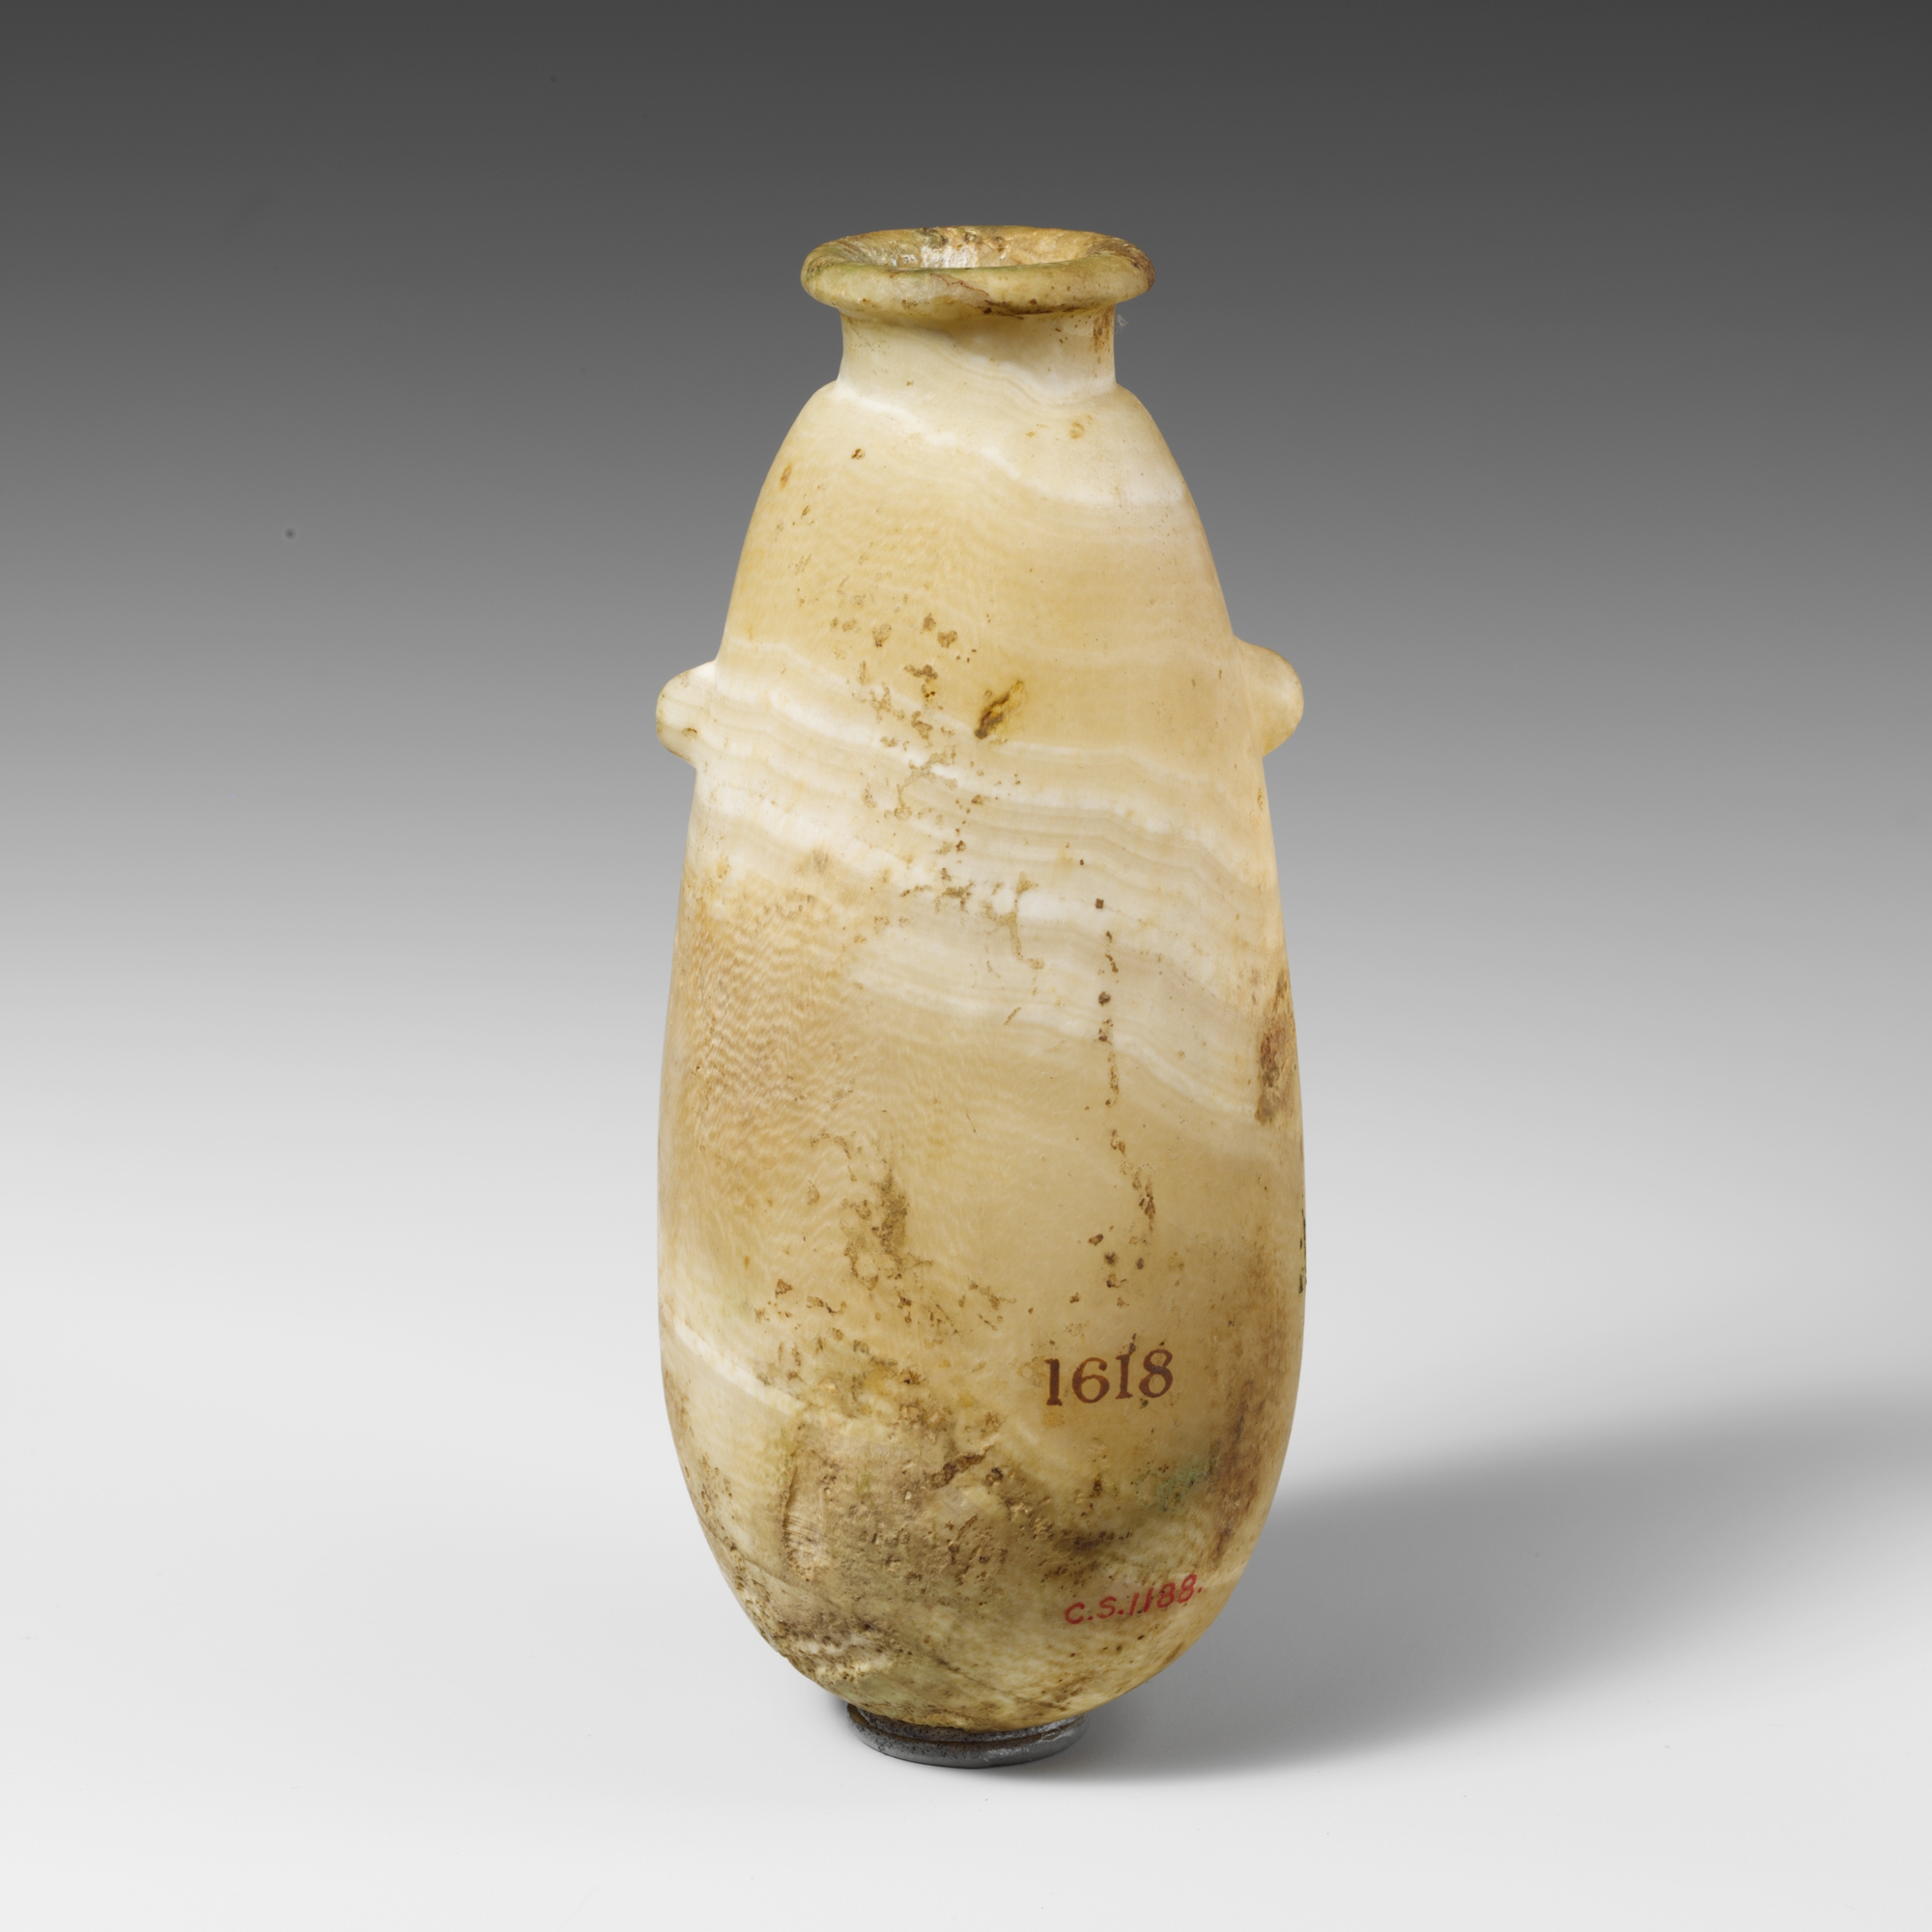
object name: alabastron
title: Alabaster alabastron (perfume vase)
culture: cypriot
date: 600-401 BCE